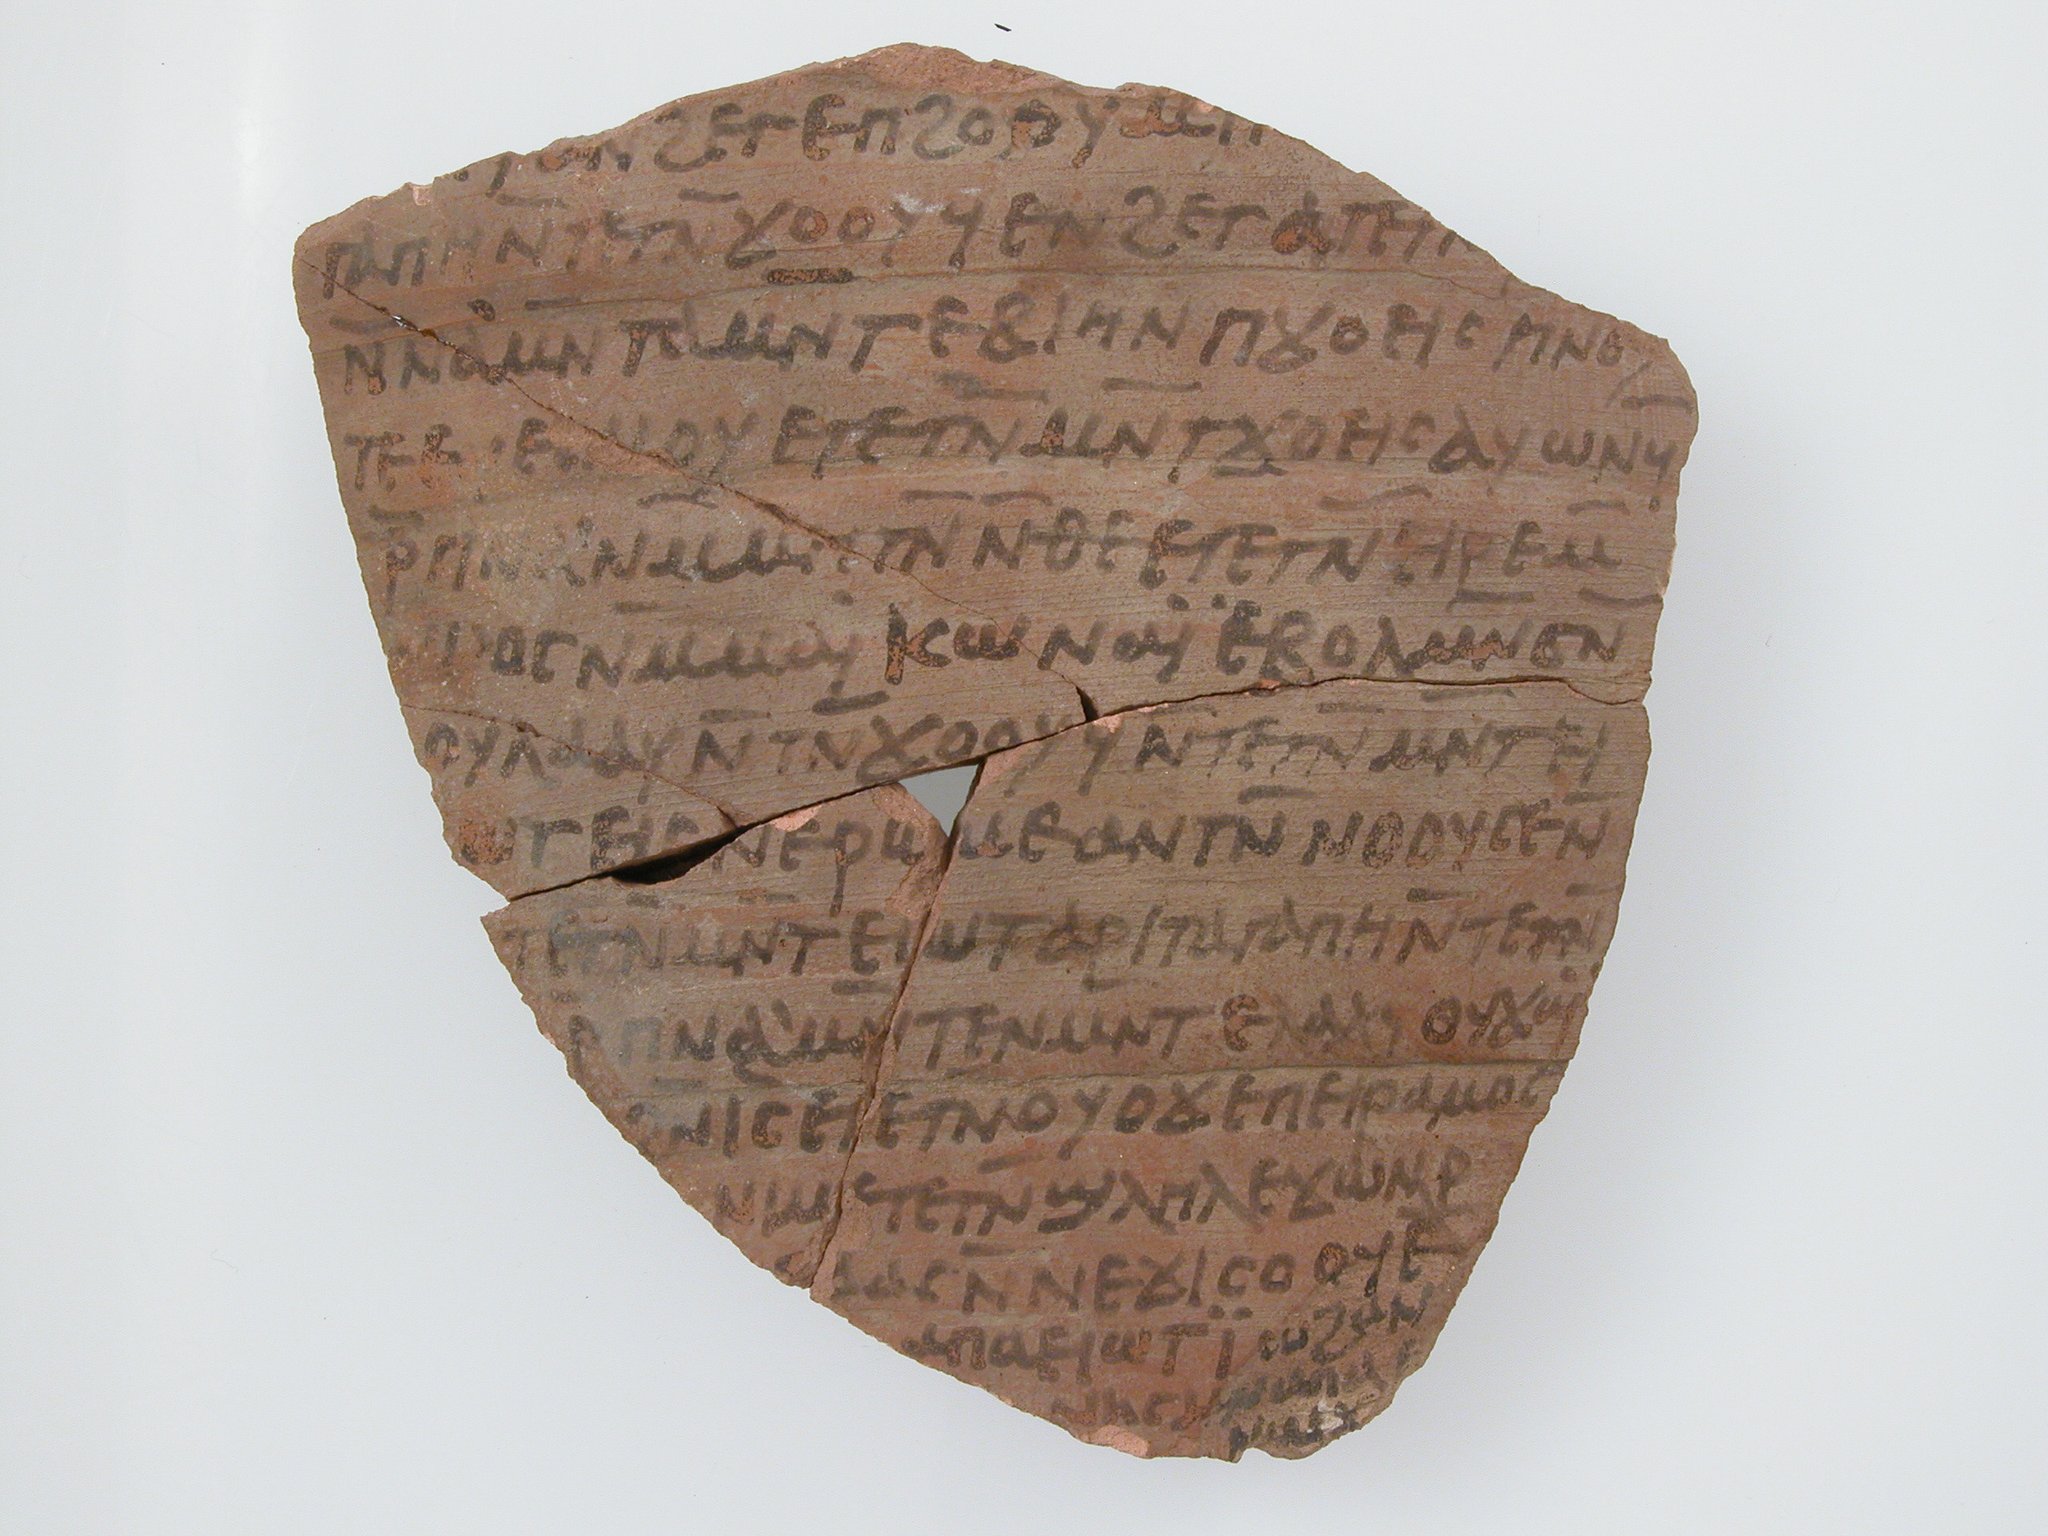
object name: ostrakon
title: Ostrakon with a Letter to John and Enoch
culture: coptic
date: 600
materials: ink, pottery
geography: egypt